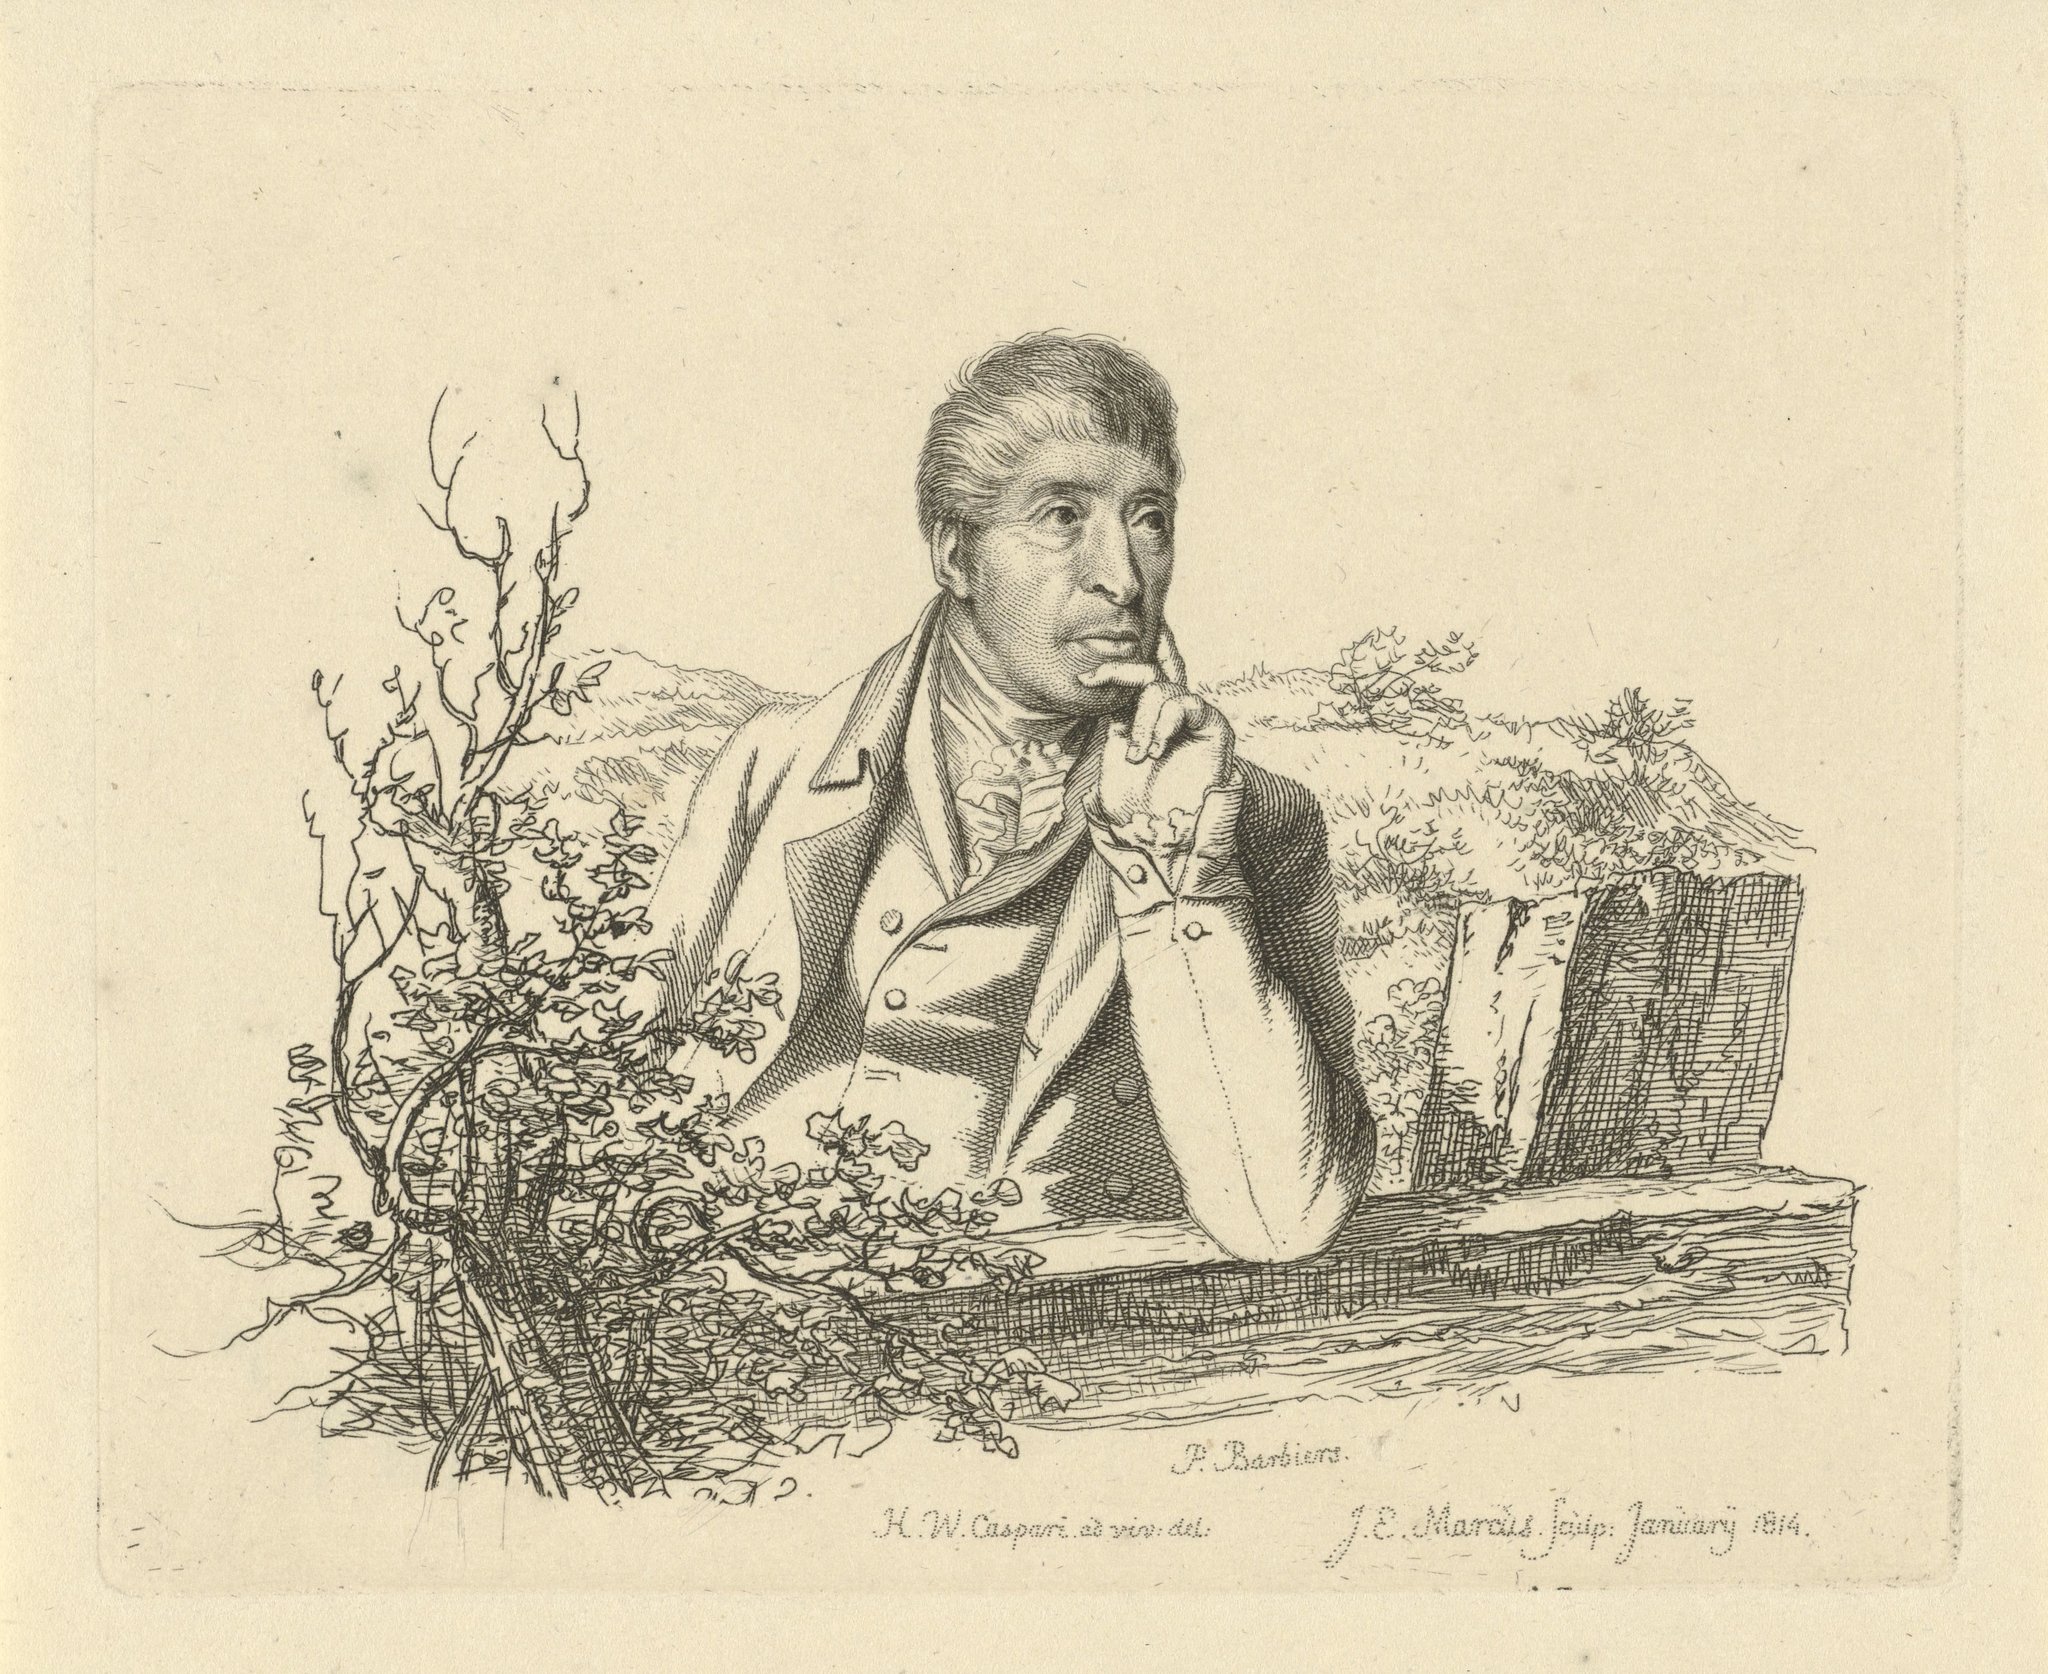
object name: print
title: Studie-prentwerk / Etudes gravées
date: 1814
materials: paper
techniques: etching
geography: amsterdam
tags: draughtsman, pieter pietersz. barbiers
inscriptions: collector's mark: Lugt 2228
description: Serie voor het eerst uitgegeven door Jacob Ernst Marcus onder de titel Studiebeelden en Fragmenten. Amsterdam: ca.1816. Later heruitgegeven als: Studie-prentwerk/ Etudes gravées.